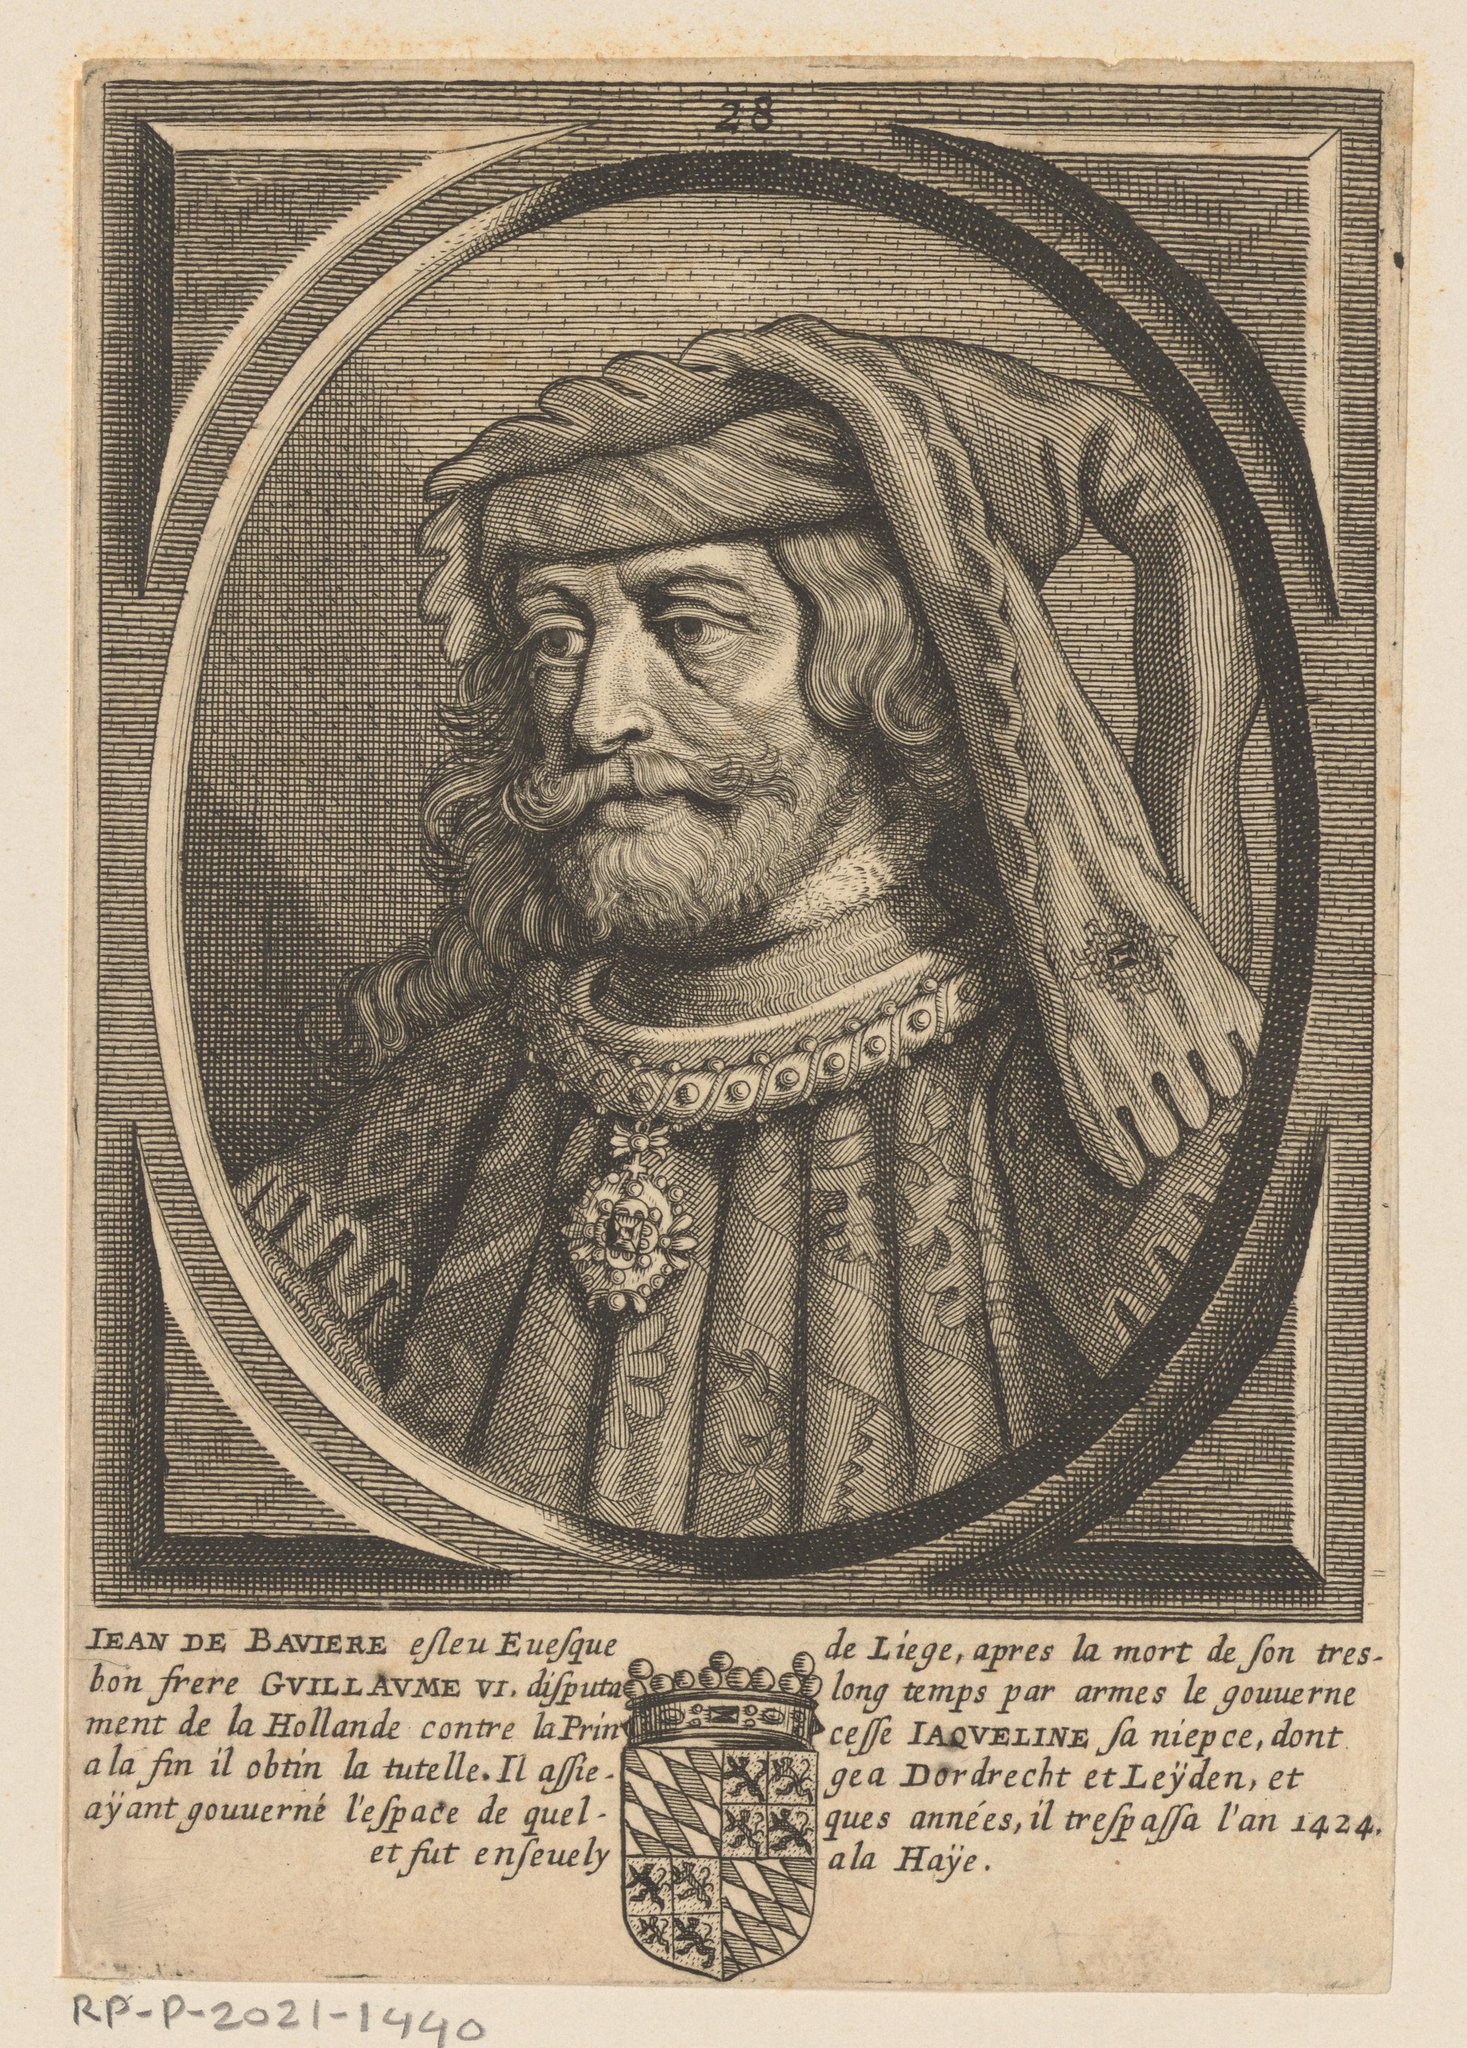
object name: print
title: Portret van Jan van Beieren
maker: cornelis meyssens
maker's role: print maker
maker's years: 1640-1673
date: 1662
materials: paper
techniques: engraving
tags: jan van beieren, historical persons, ruler, sovereign, armorial bearing, heraldry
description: Prent mogelijk uit: Meyssens, Joannes. Les portraits des souvereins, princes et comtes de Hollande par Jean Meyssens, peintre et gravez par son fils Cornille Meyssens l'an 1662. Antwerpen: Joannes Meyssens, 1662.